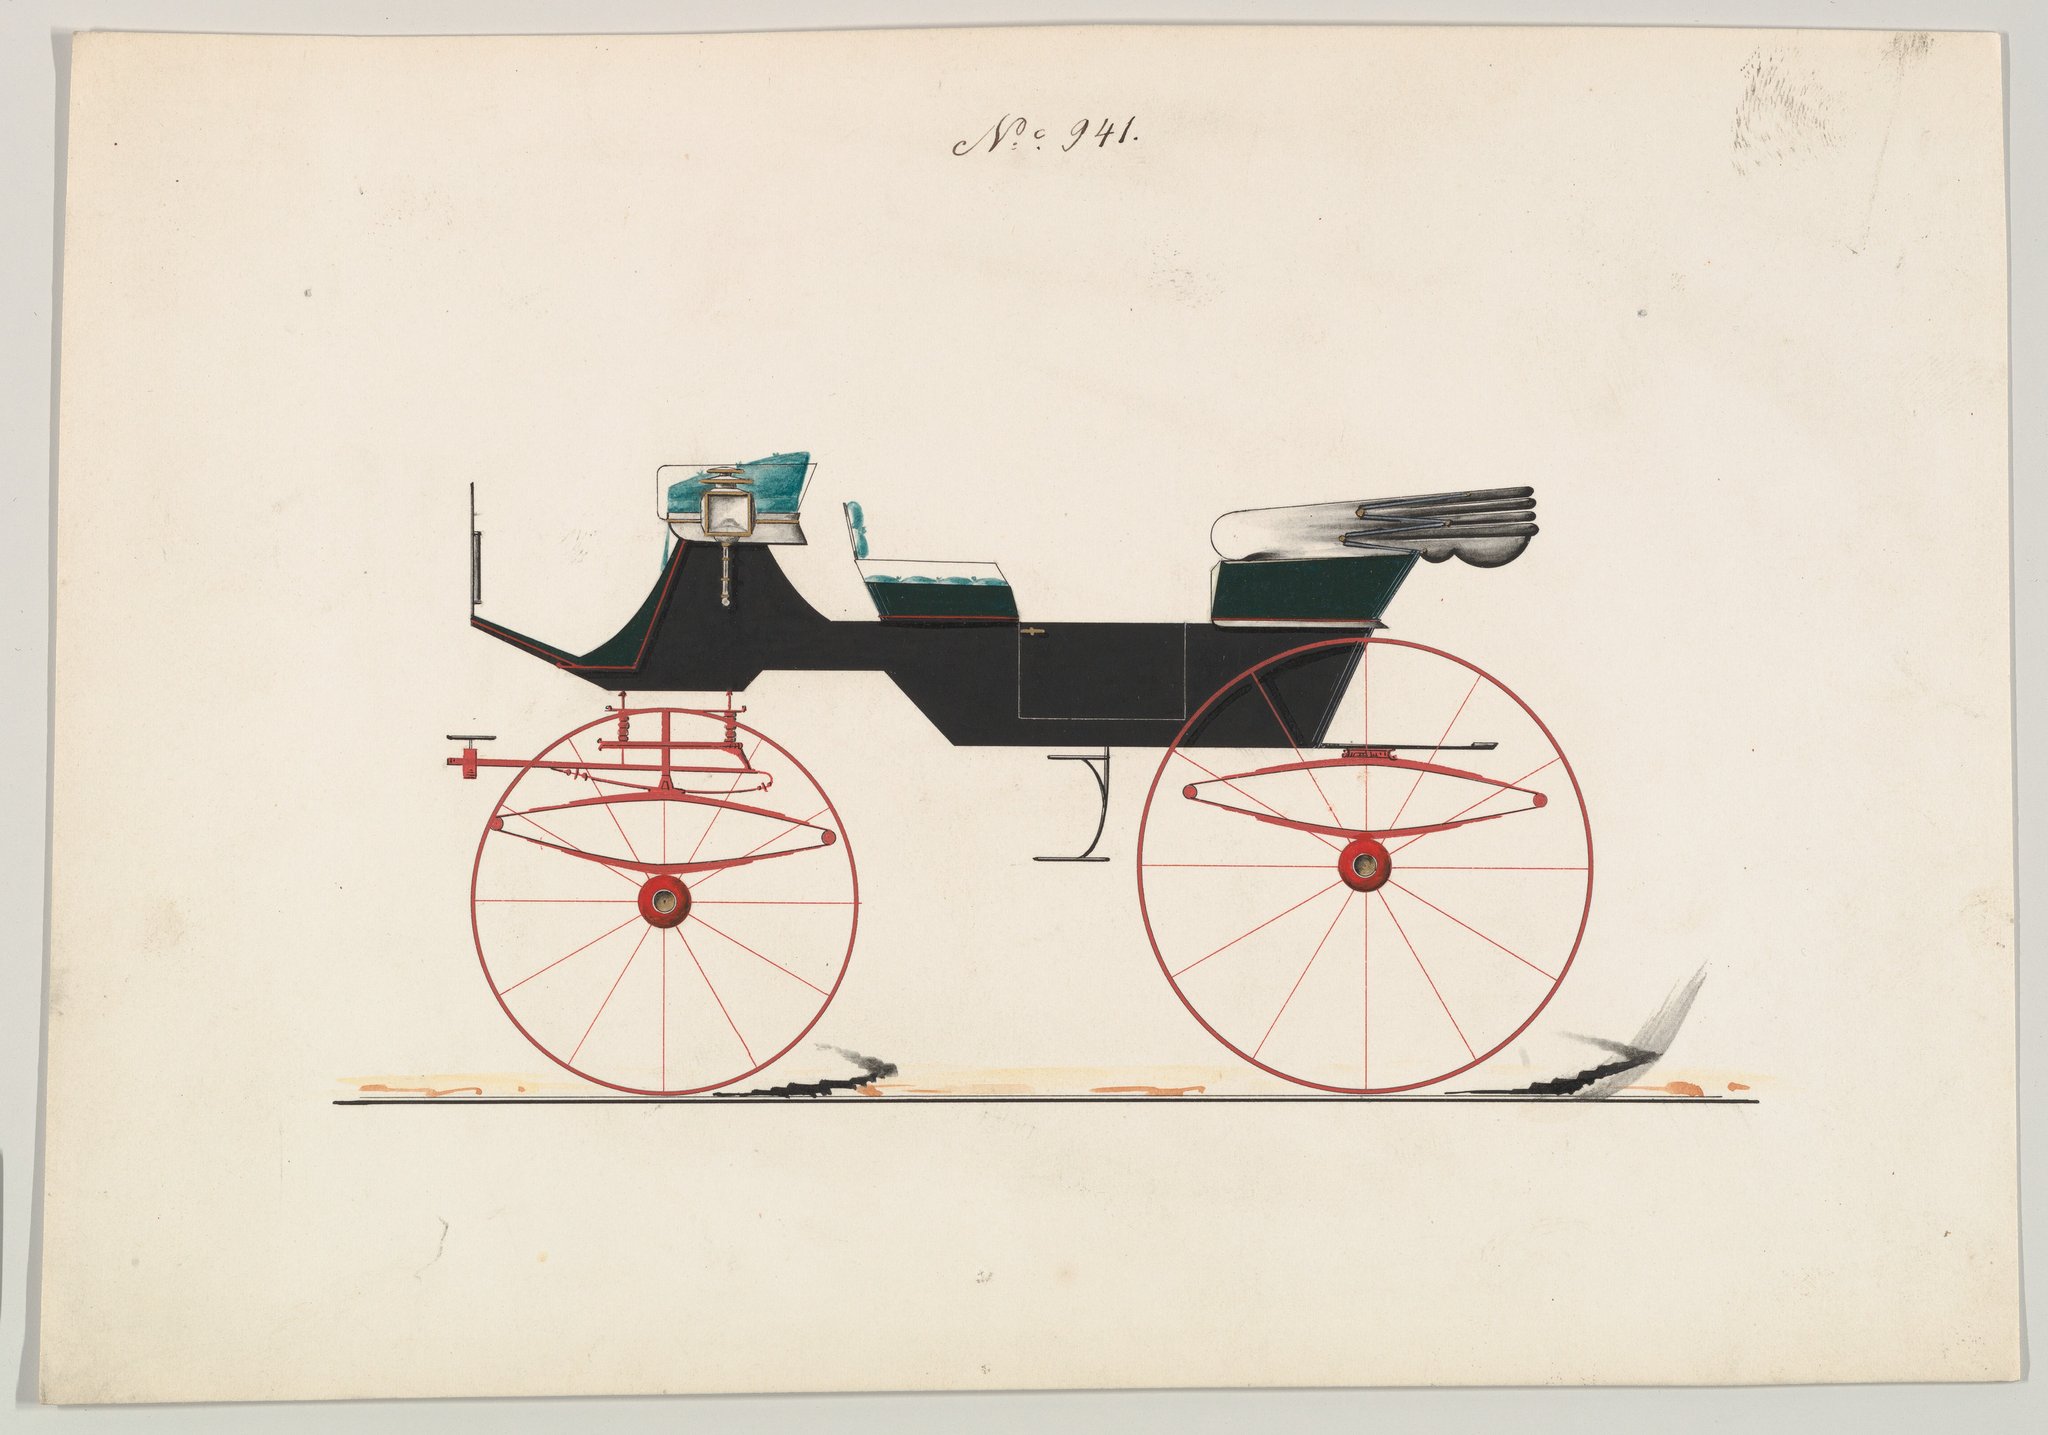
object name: drawing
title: Design for Vis-à-vis, no. 941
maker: brewster & co.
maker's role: manufacturer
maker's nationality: american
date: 1870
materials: gouache, gum arabic, ink, watercolor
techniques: pen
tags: carriages